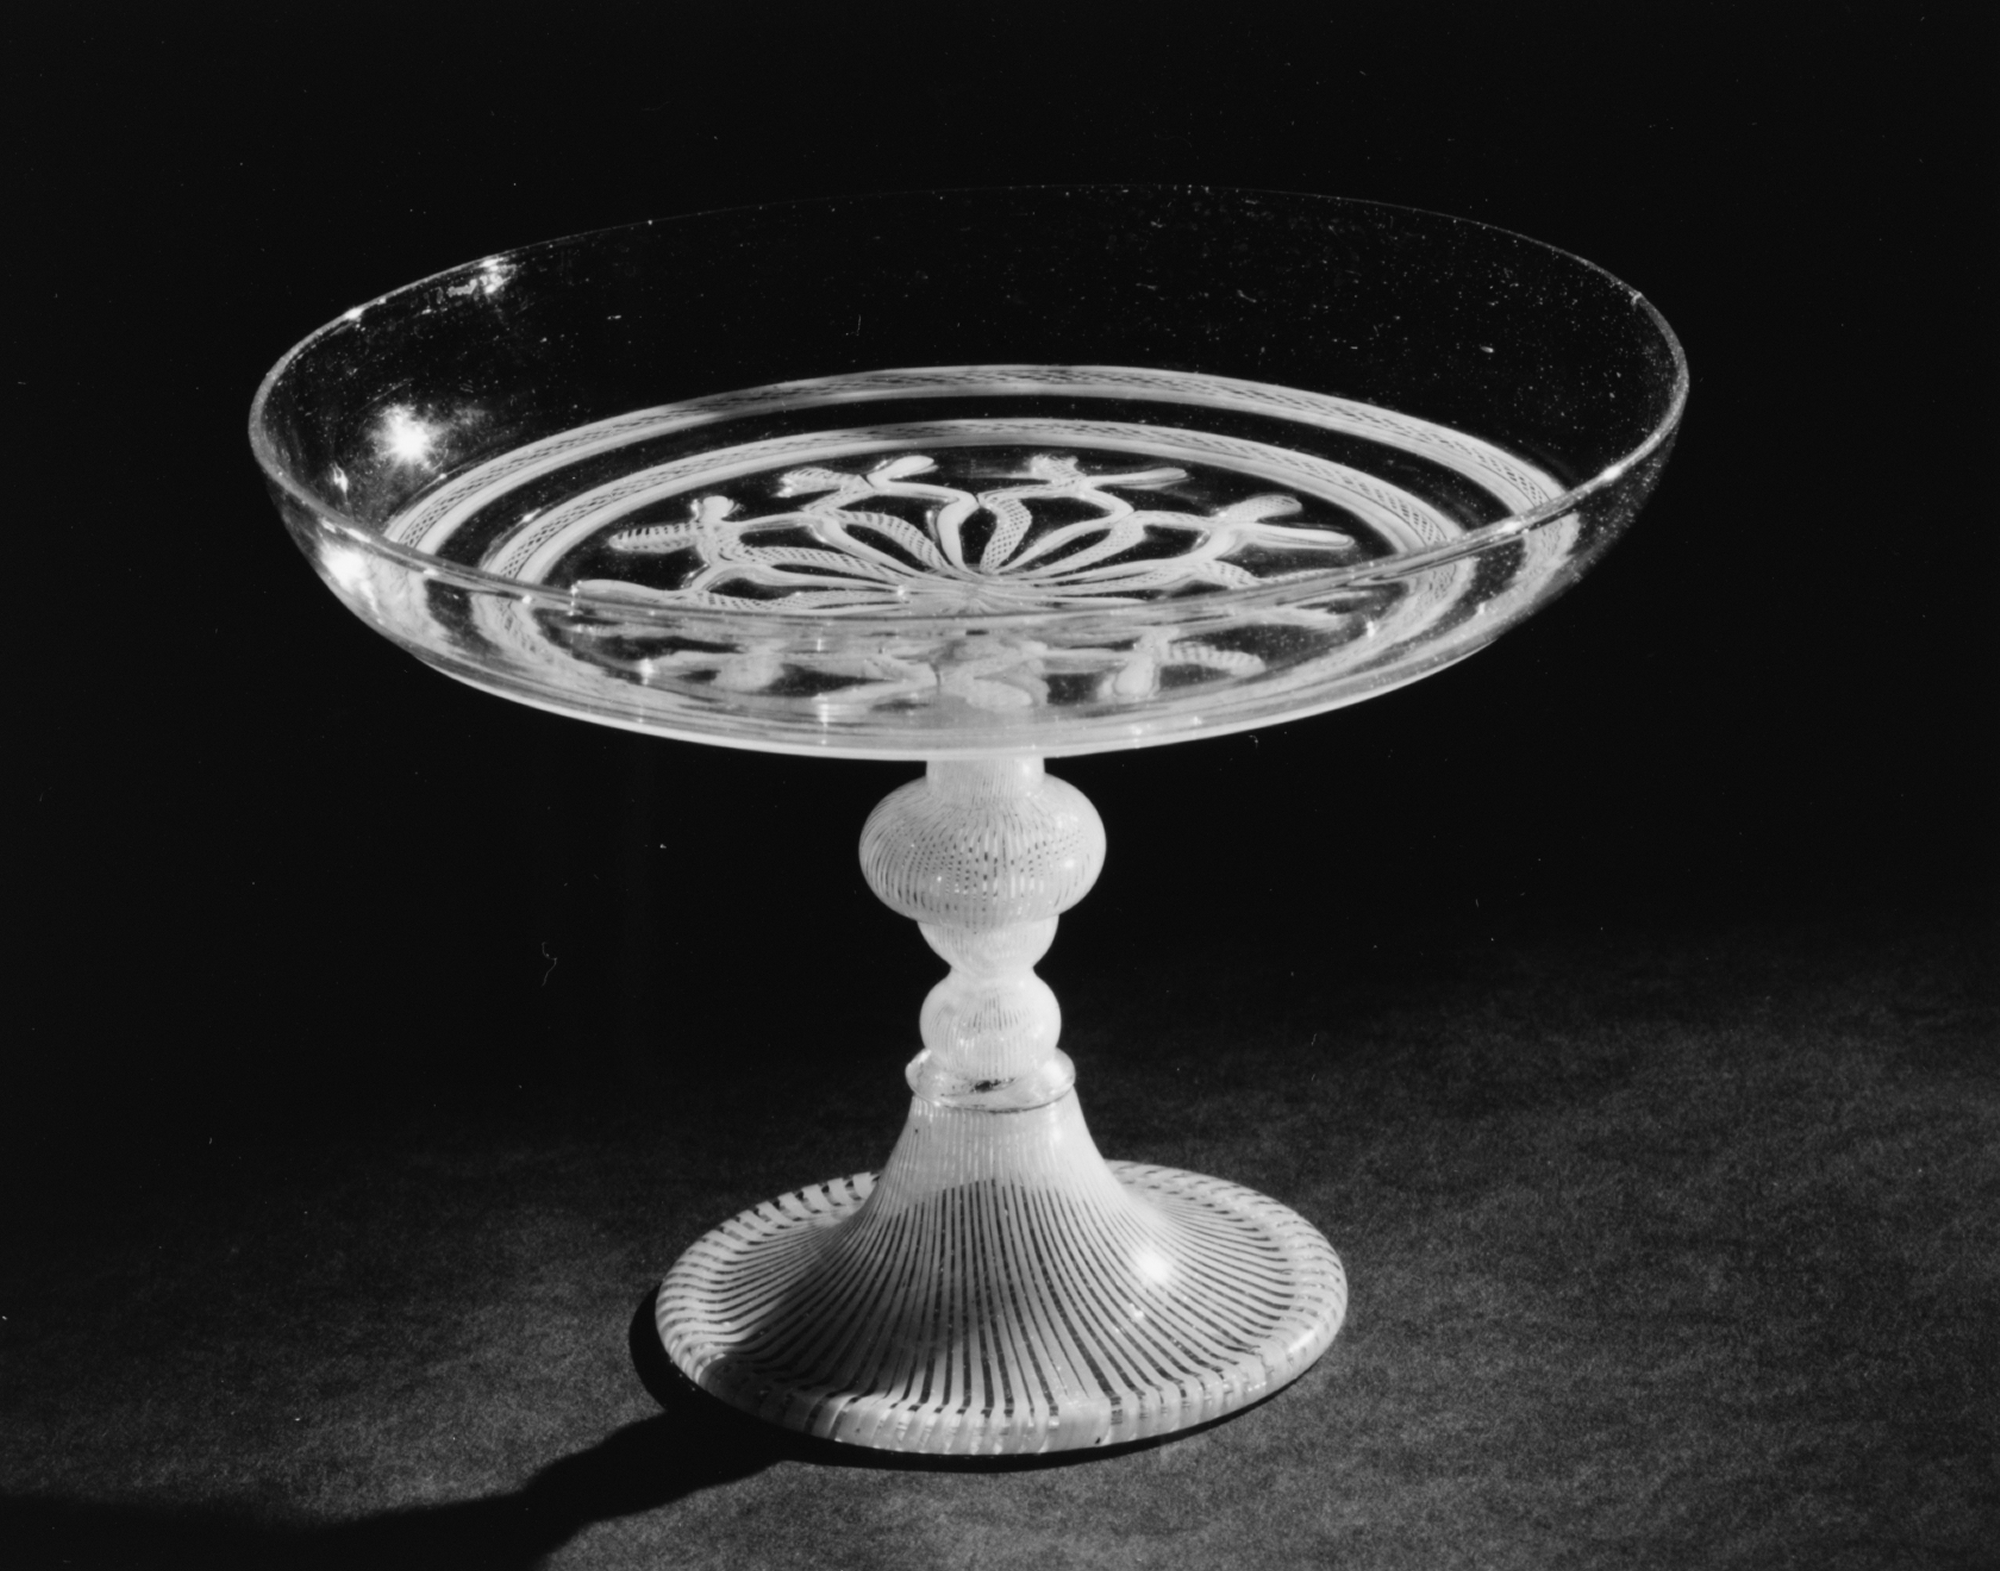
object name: tazza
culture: venetian or façon de venise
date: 1501-1550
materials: glass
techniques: glassblowing